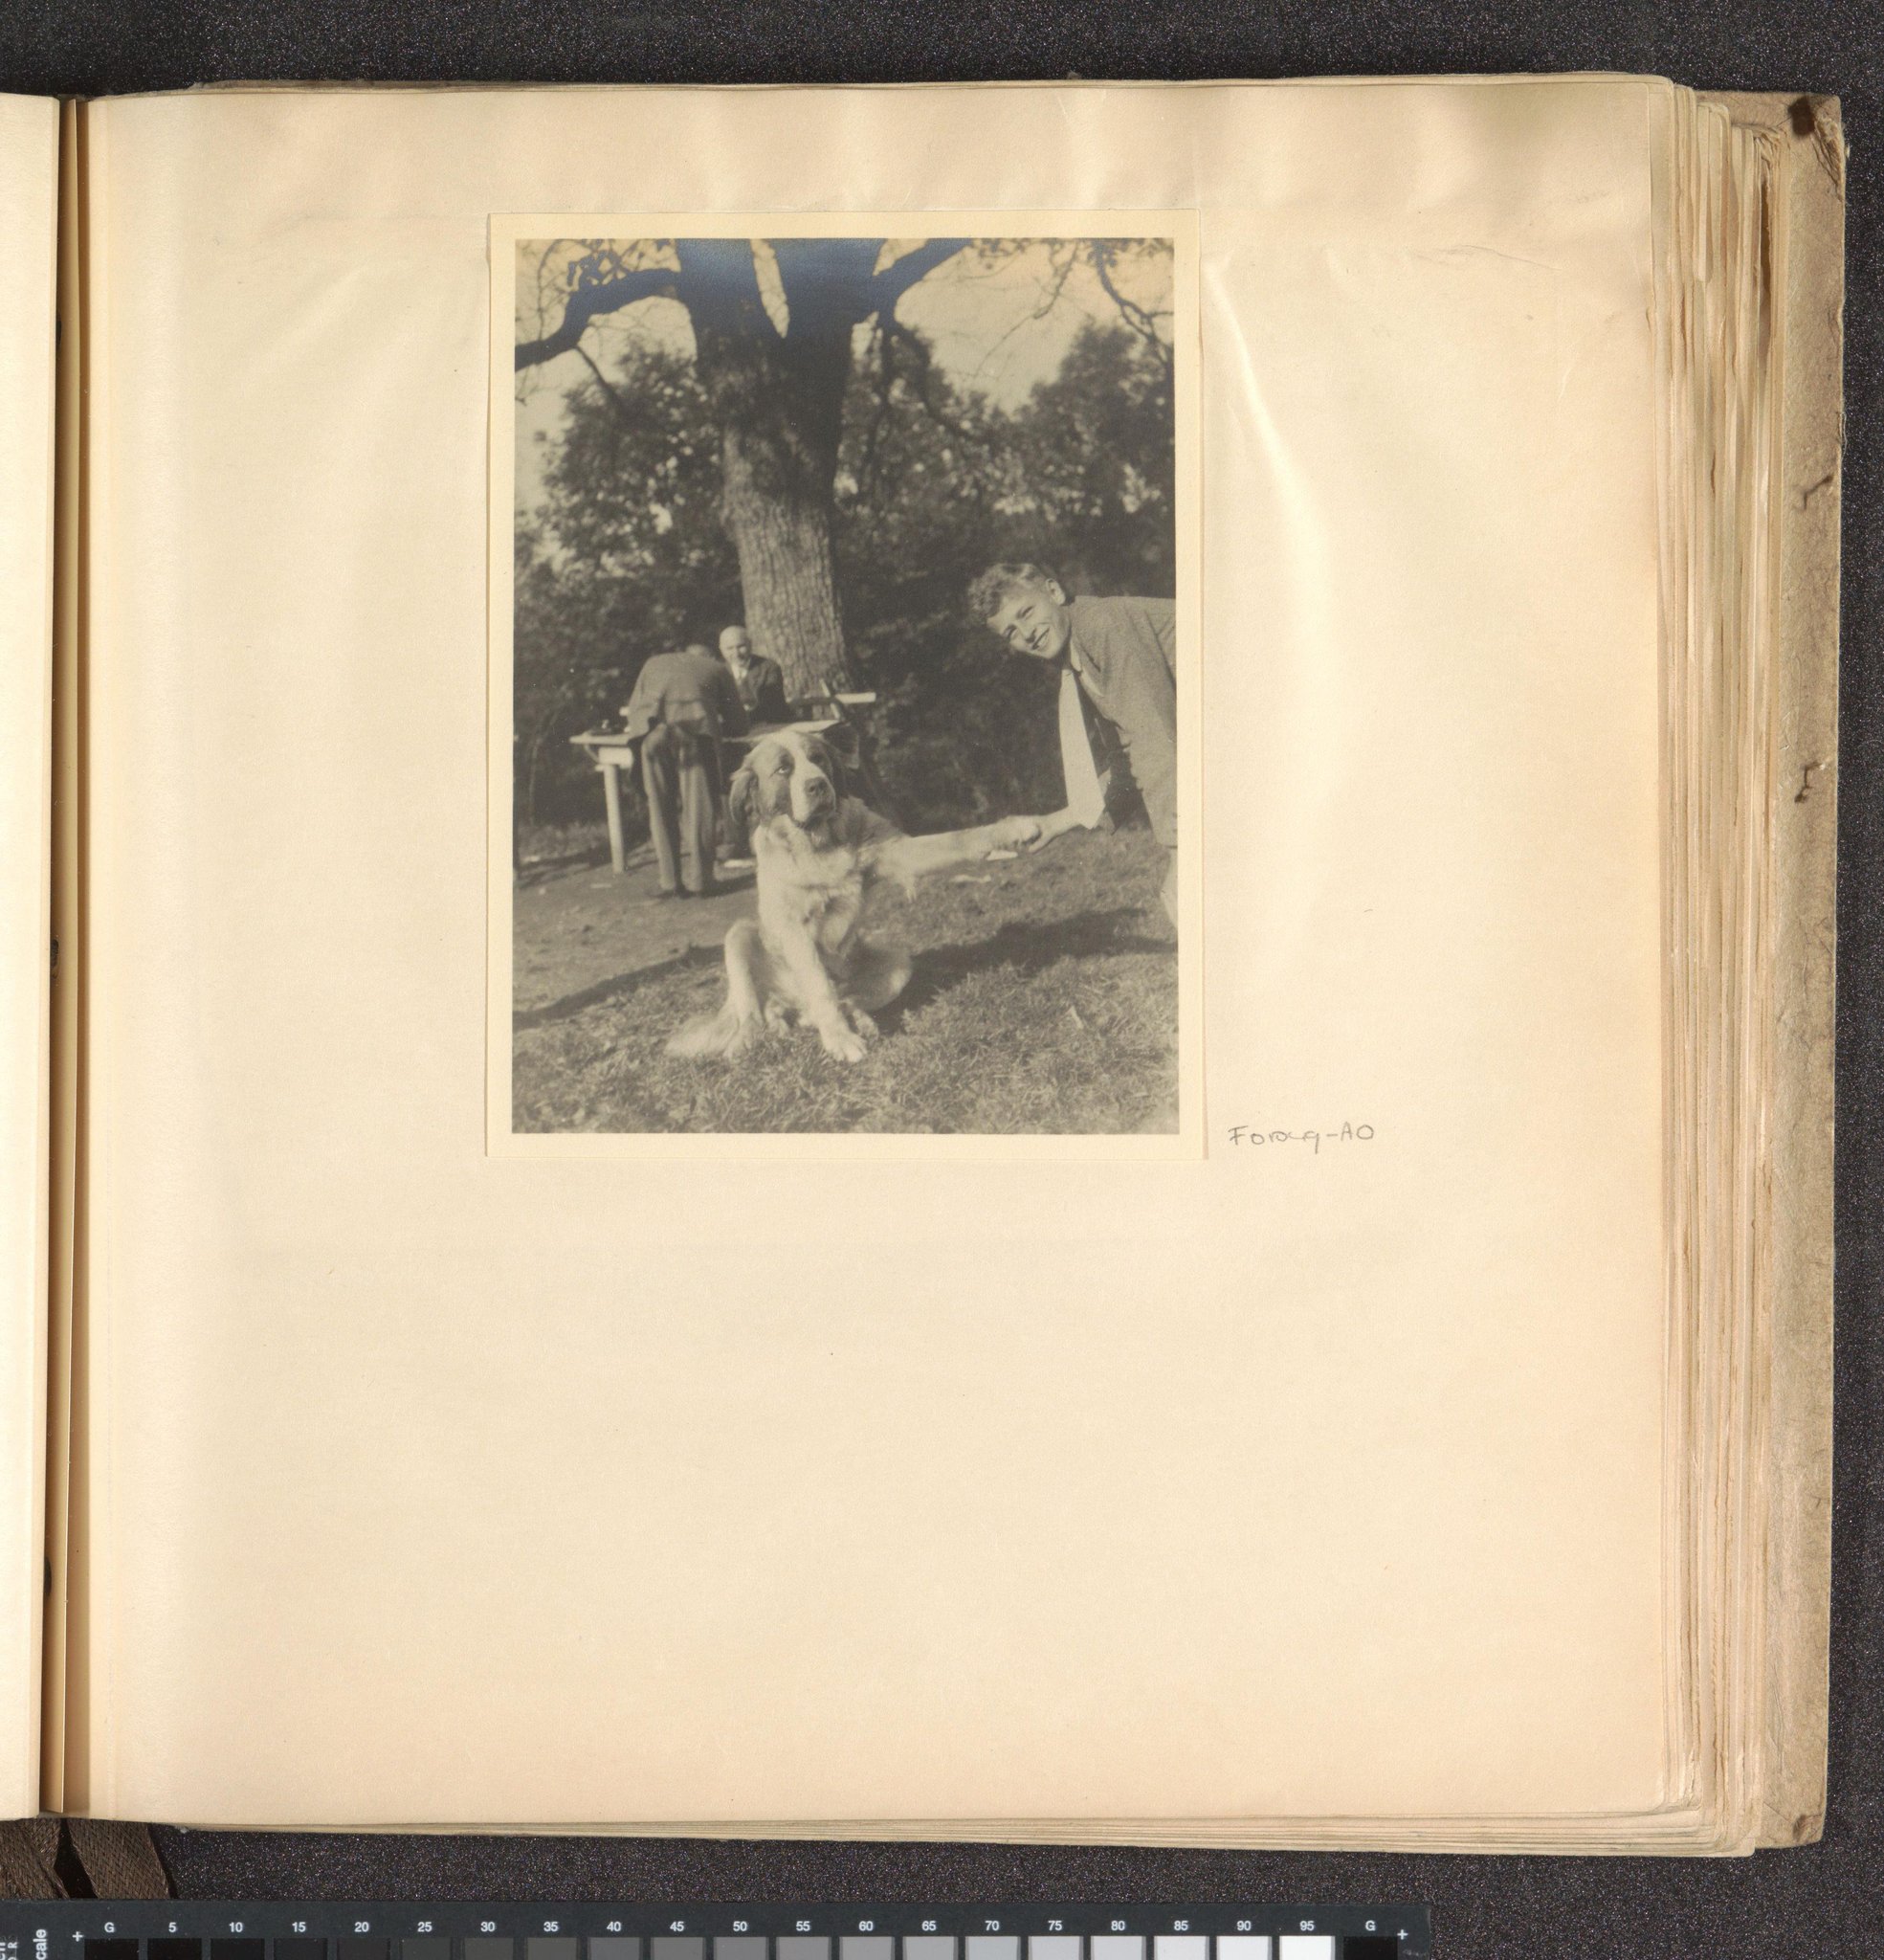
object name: photograph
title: Leerling van Schule Schloss Salem met hond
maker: Anonymous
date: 1929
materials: photographic support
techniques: gelatin silver print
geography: salem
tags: training of performing dog, education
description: Onderdeel van Fotoalbum van Schule Schloss Salem.